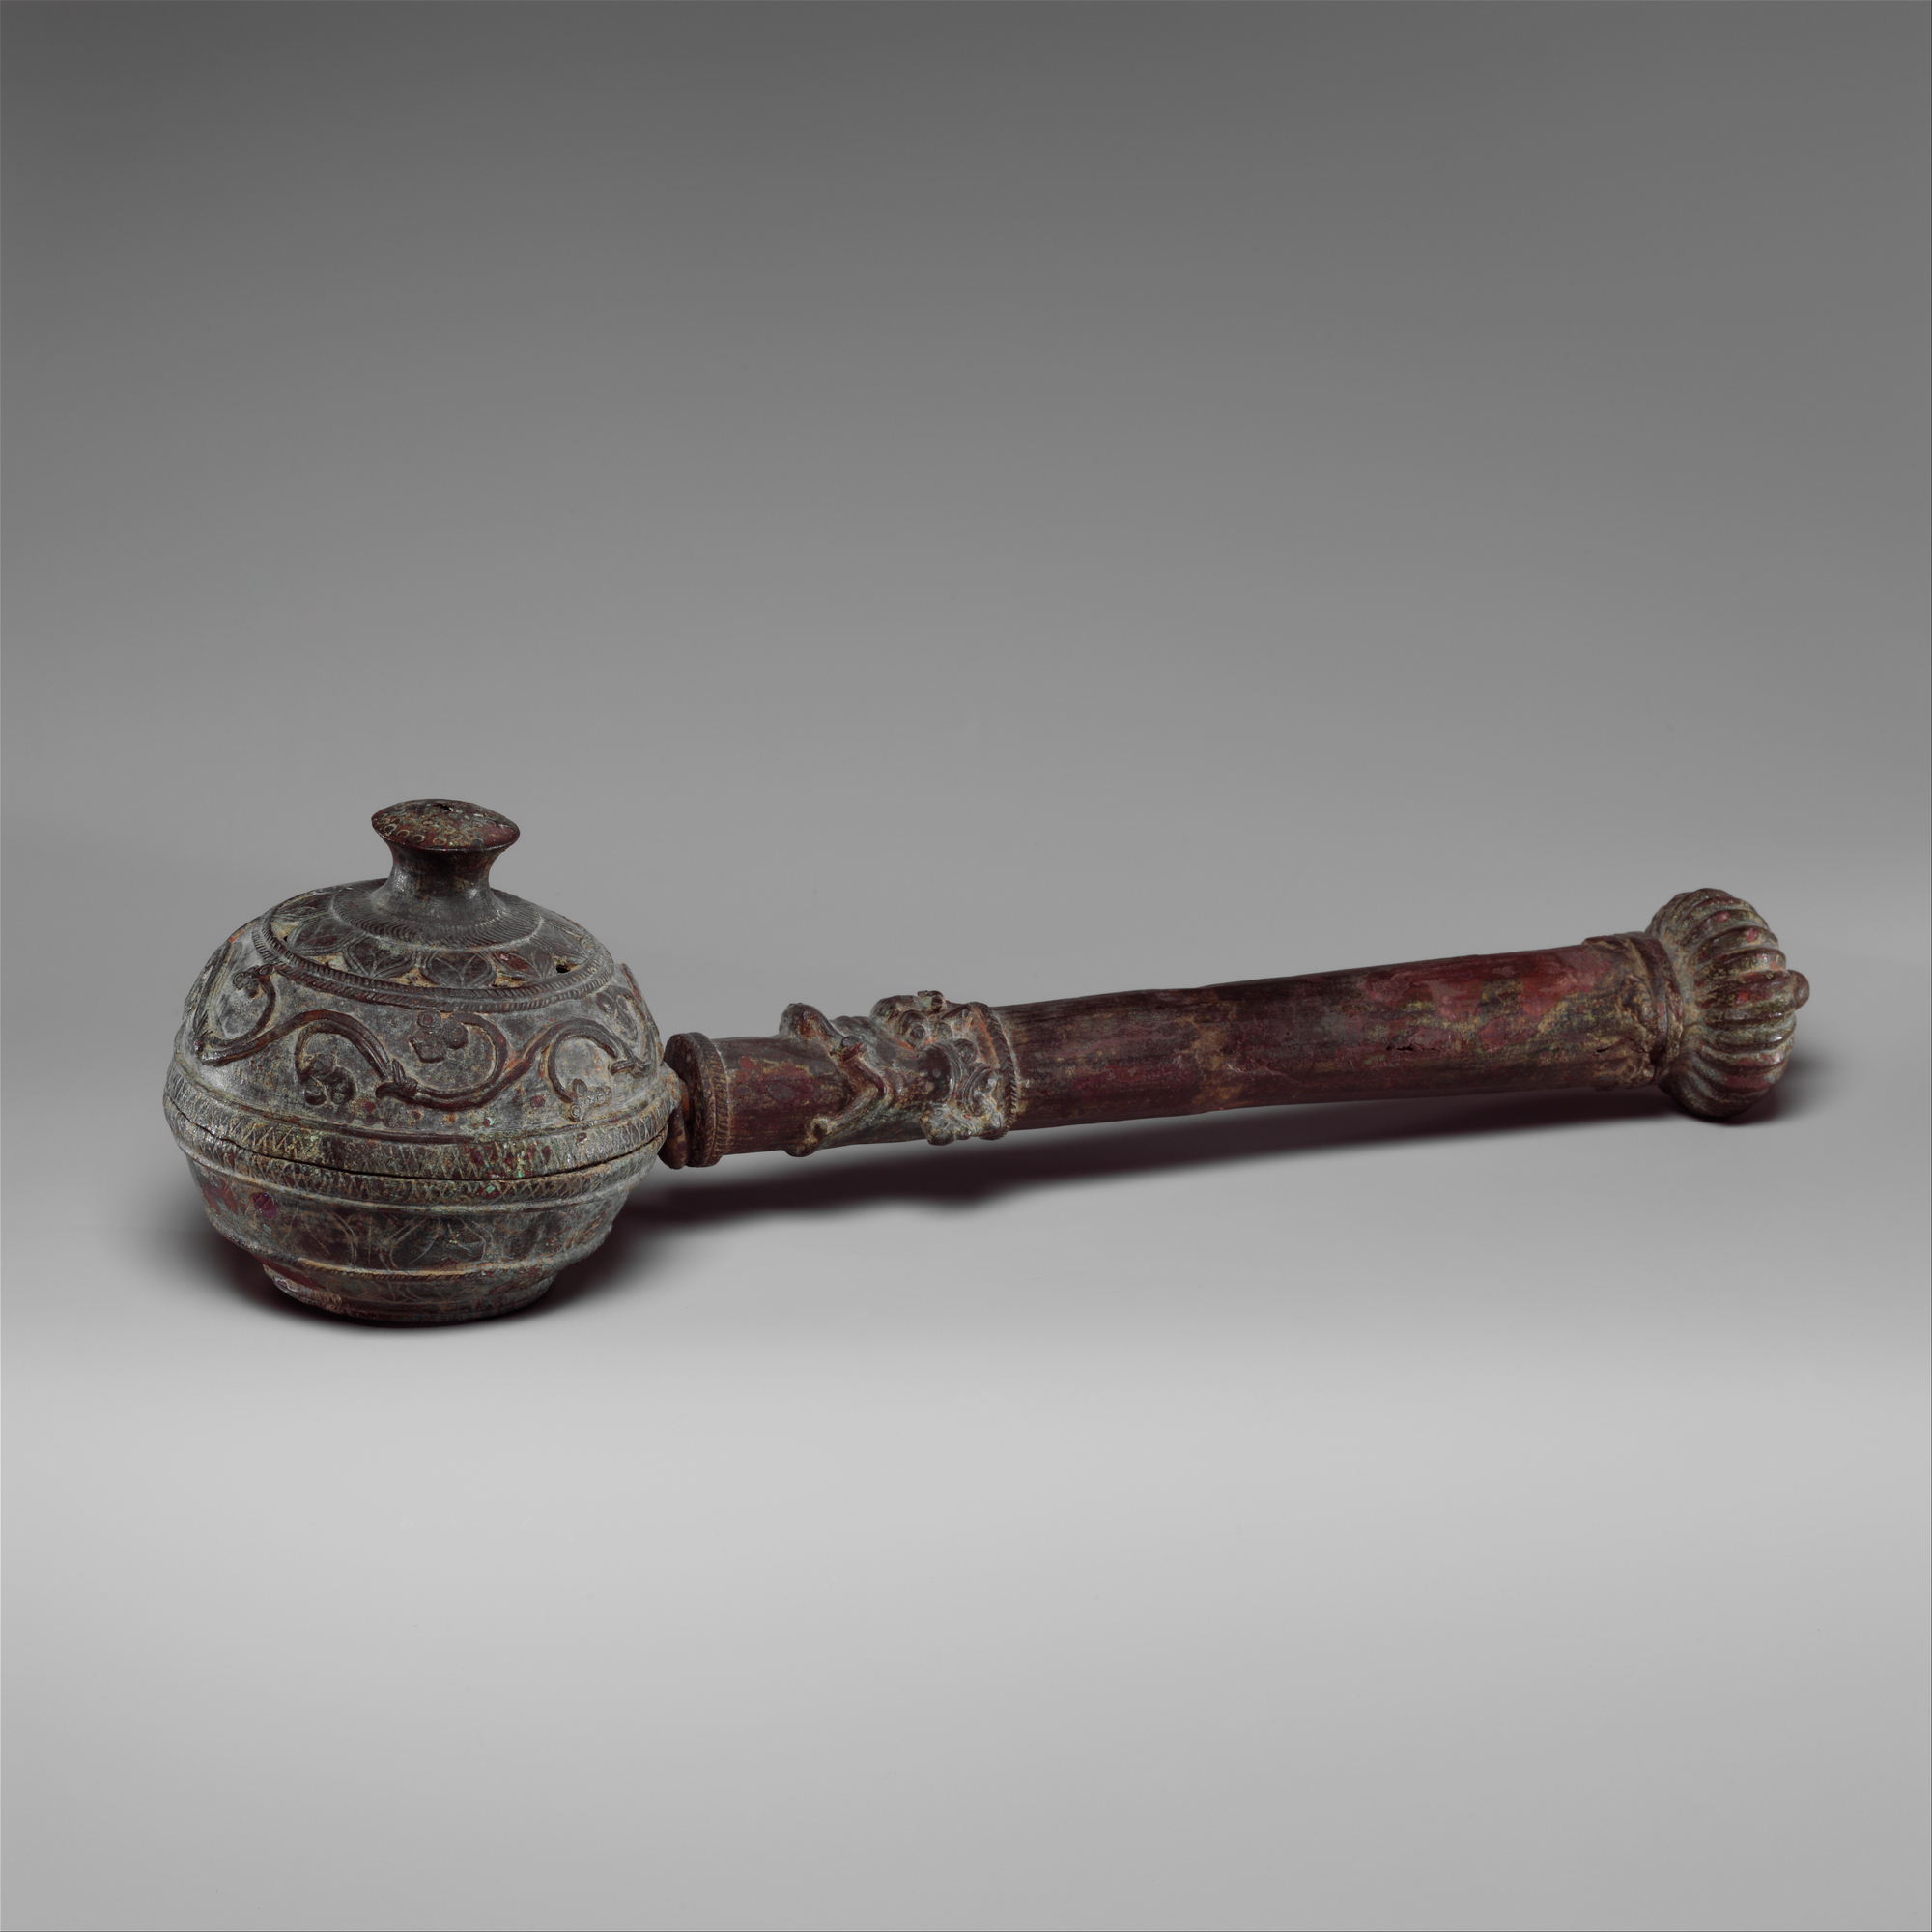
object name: censer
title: Ritual Incense Burner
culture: gandhara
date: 501-600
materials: bronze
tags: gandhara